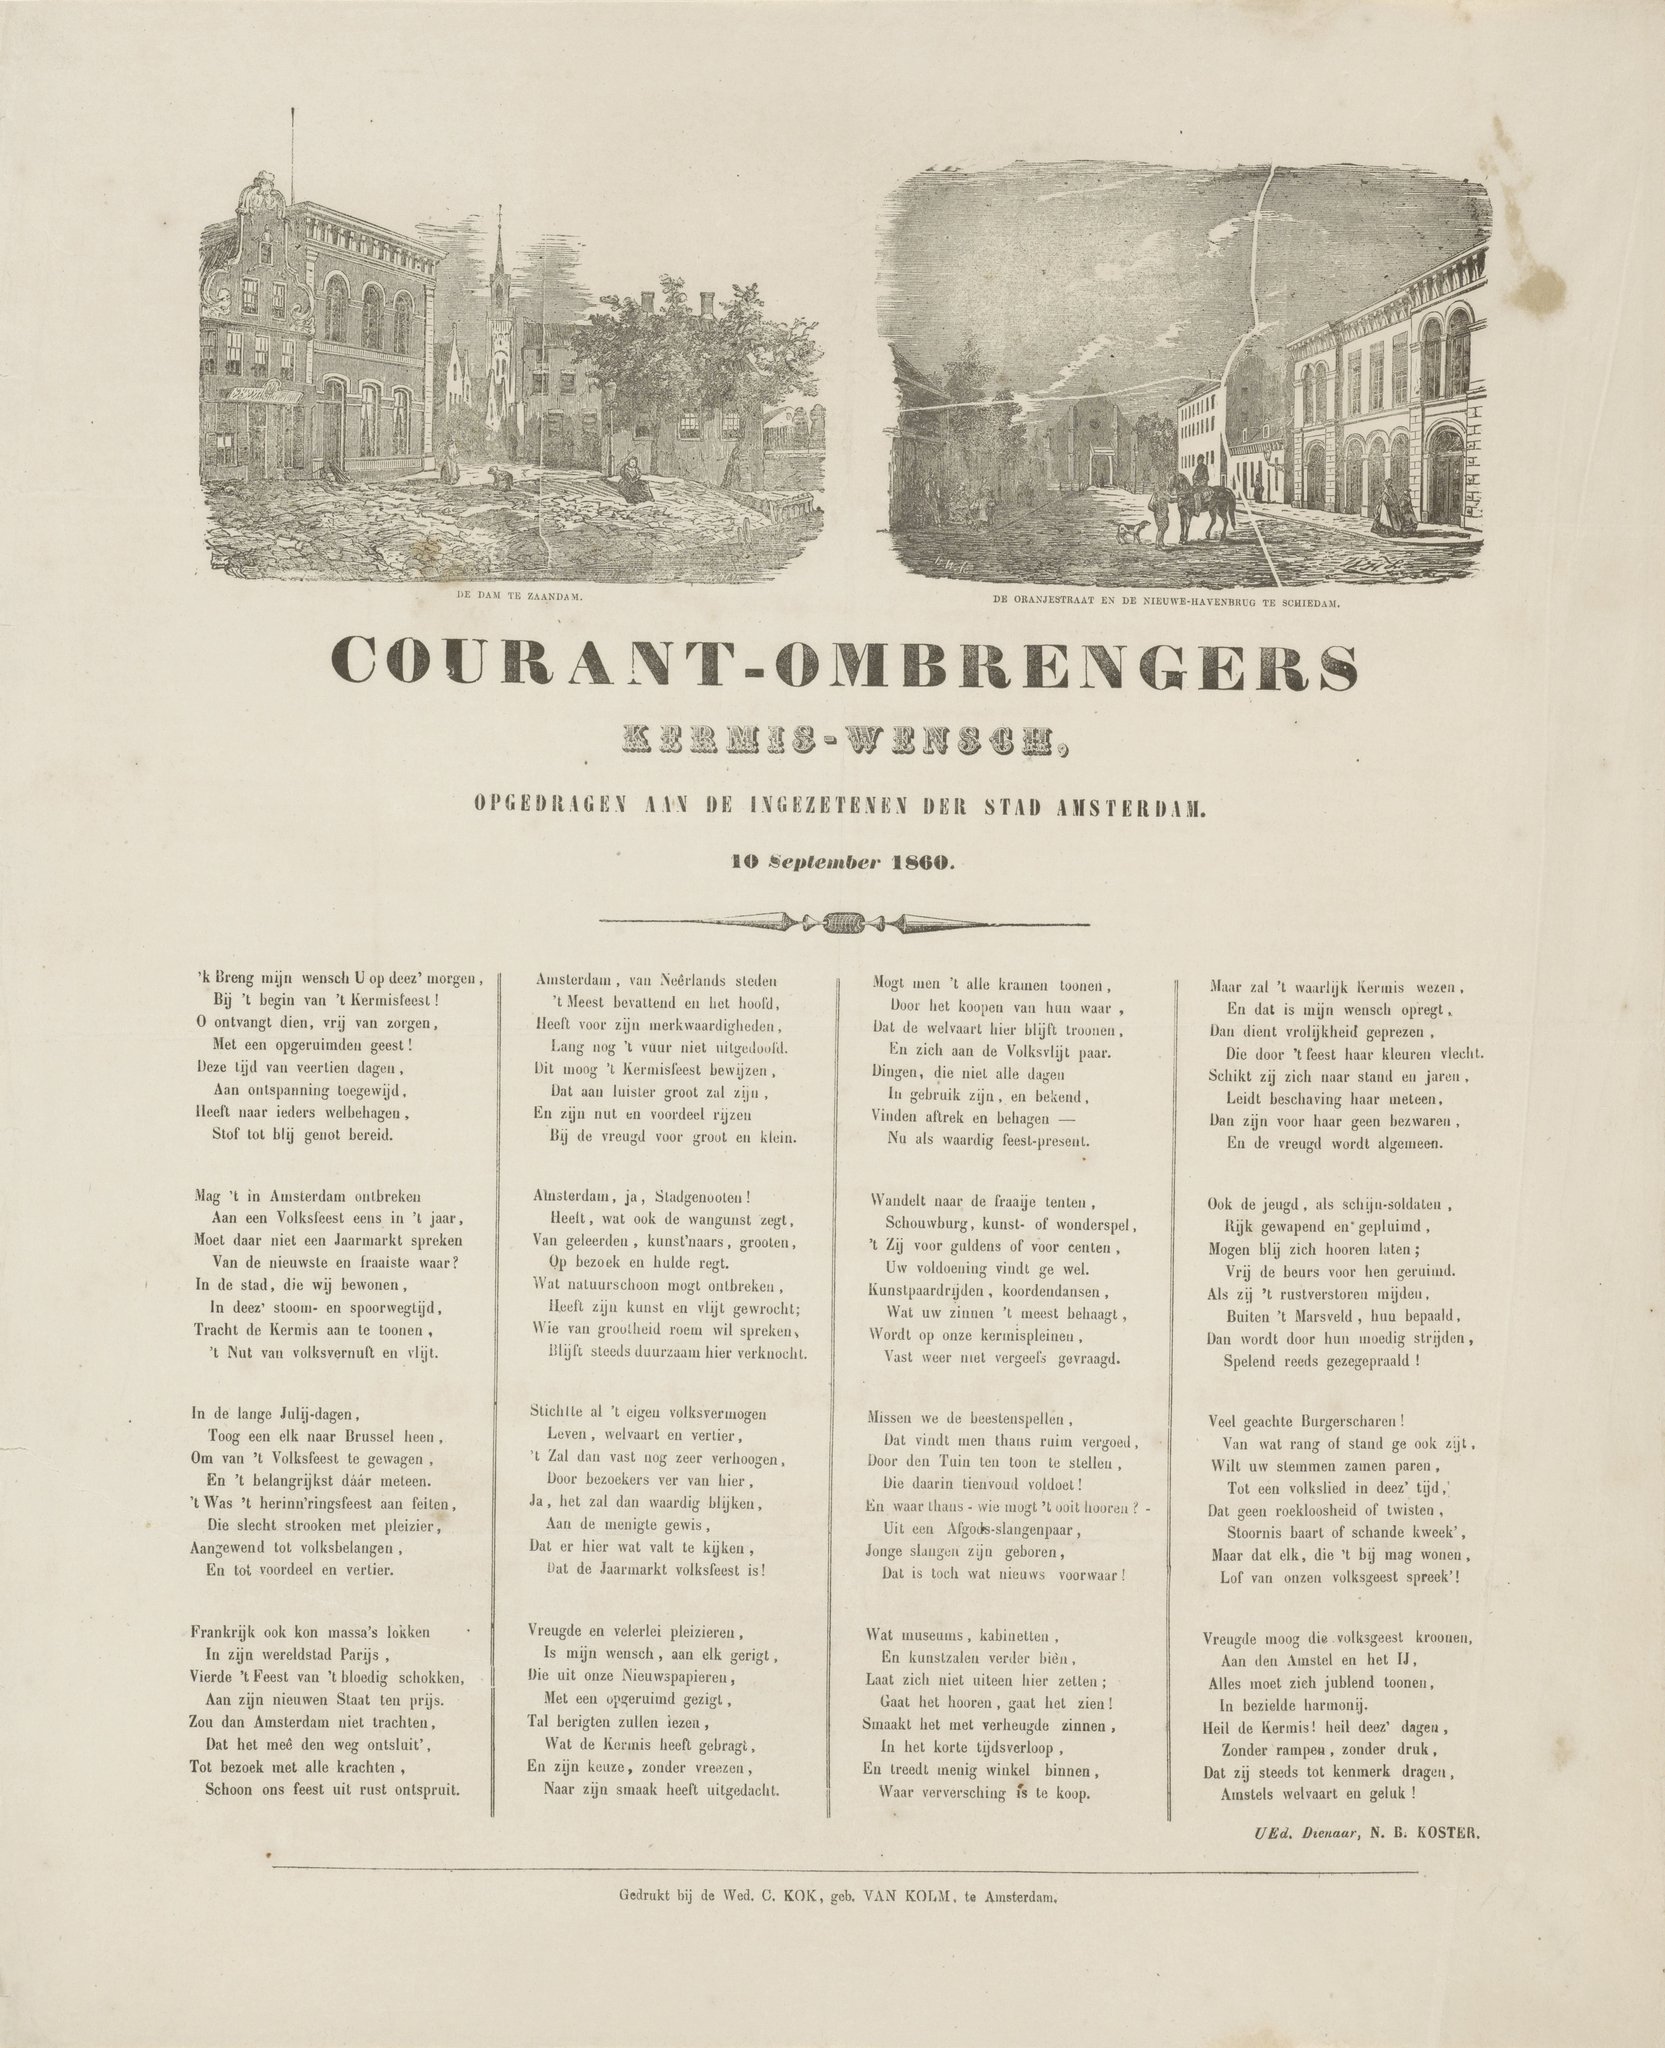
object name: print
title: Kermisprent van de Amsterdamse courantombrengers voor het jaar 1860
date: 1860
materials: paper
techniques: letterpress printing, engraving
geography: amsterdam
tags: public road - ii - ideal city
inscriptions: collector's mark: Lugt 2228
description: Kermisprent namens de ombrengers van couranten (krantenbezorgers) te Amsterdam, 10 september 1860. Bovenaan twee vignetten met afbeeldingen ontleend aan boeken, links de Dam te Zaandam, rechts de Oranjestraat en de Nieuwe Havenbrug te Schiedam. Onderaan een gedicht in vier kolommen. Van de courantombrenger: N.B. Koster.